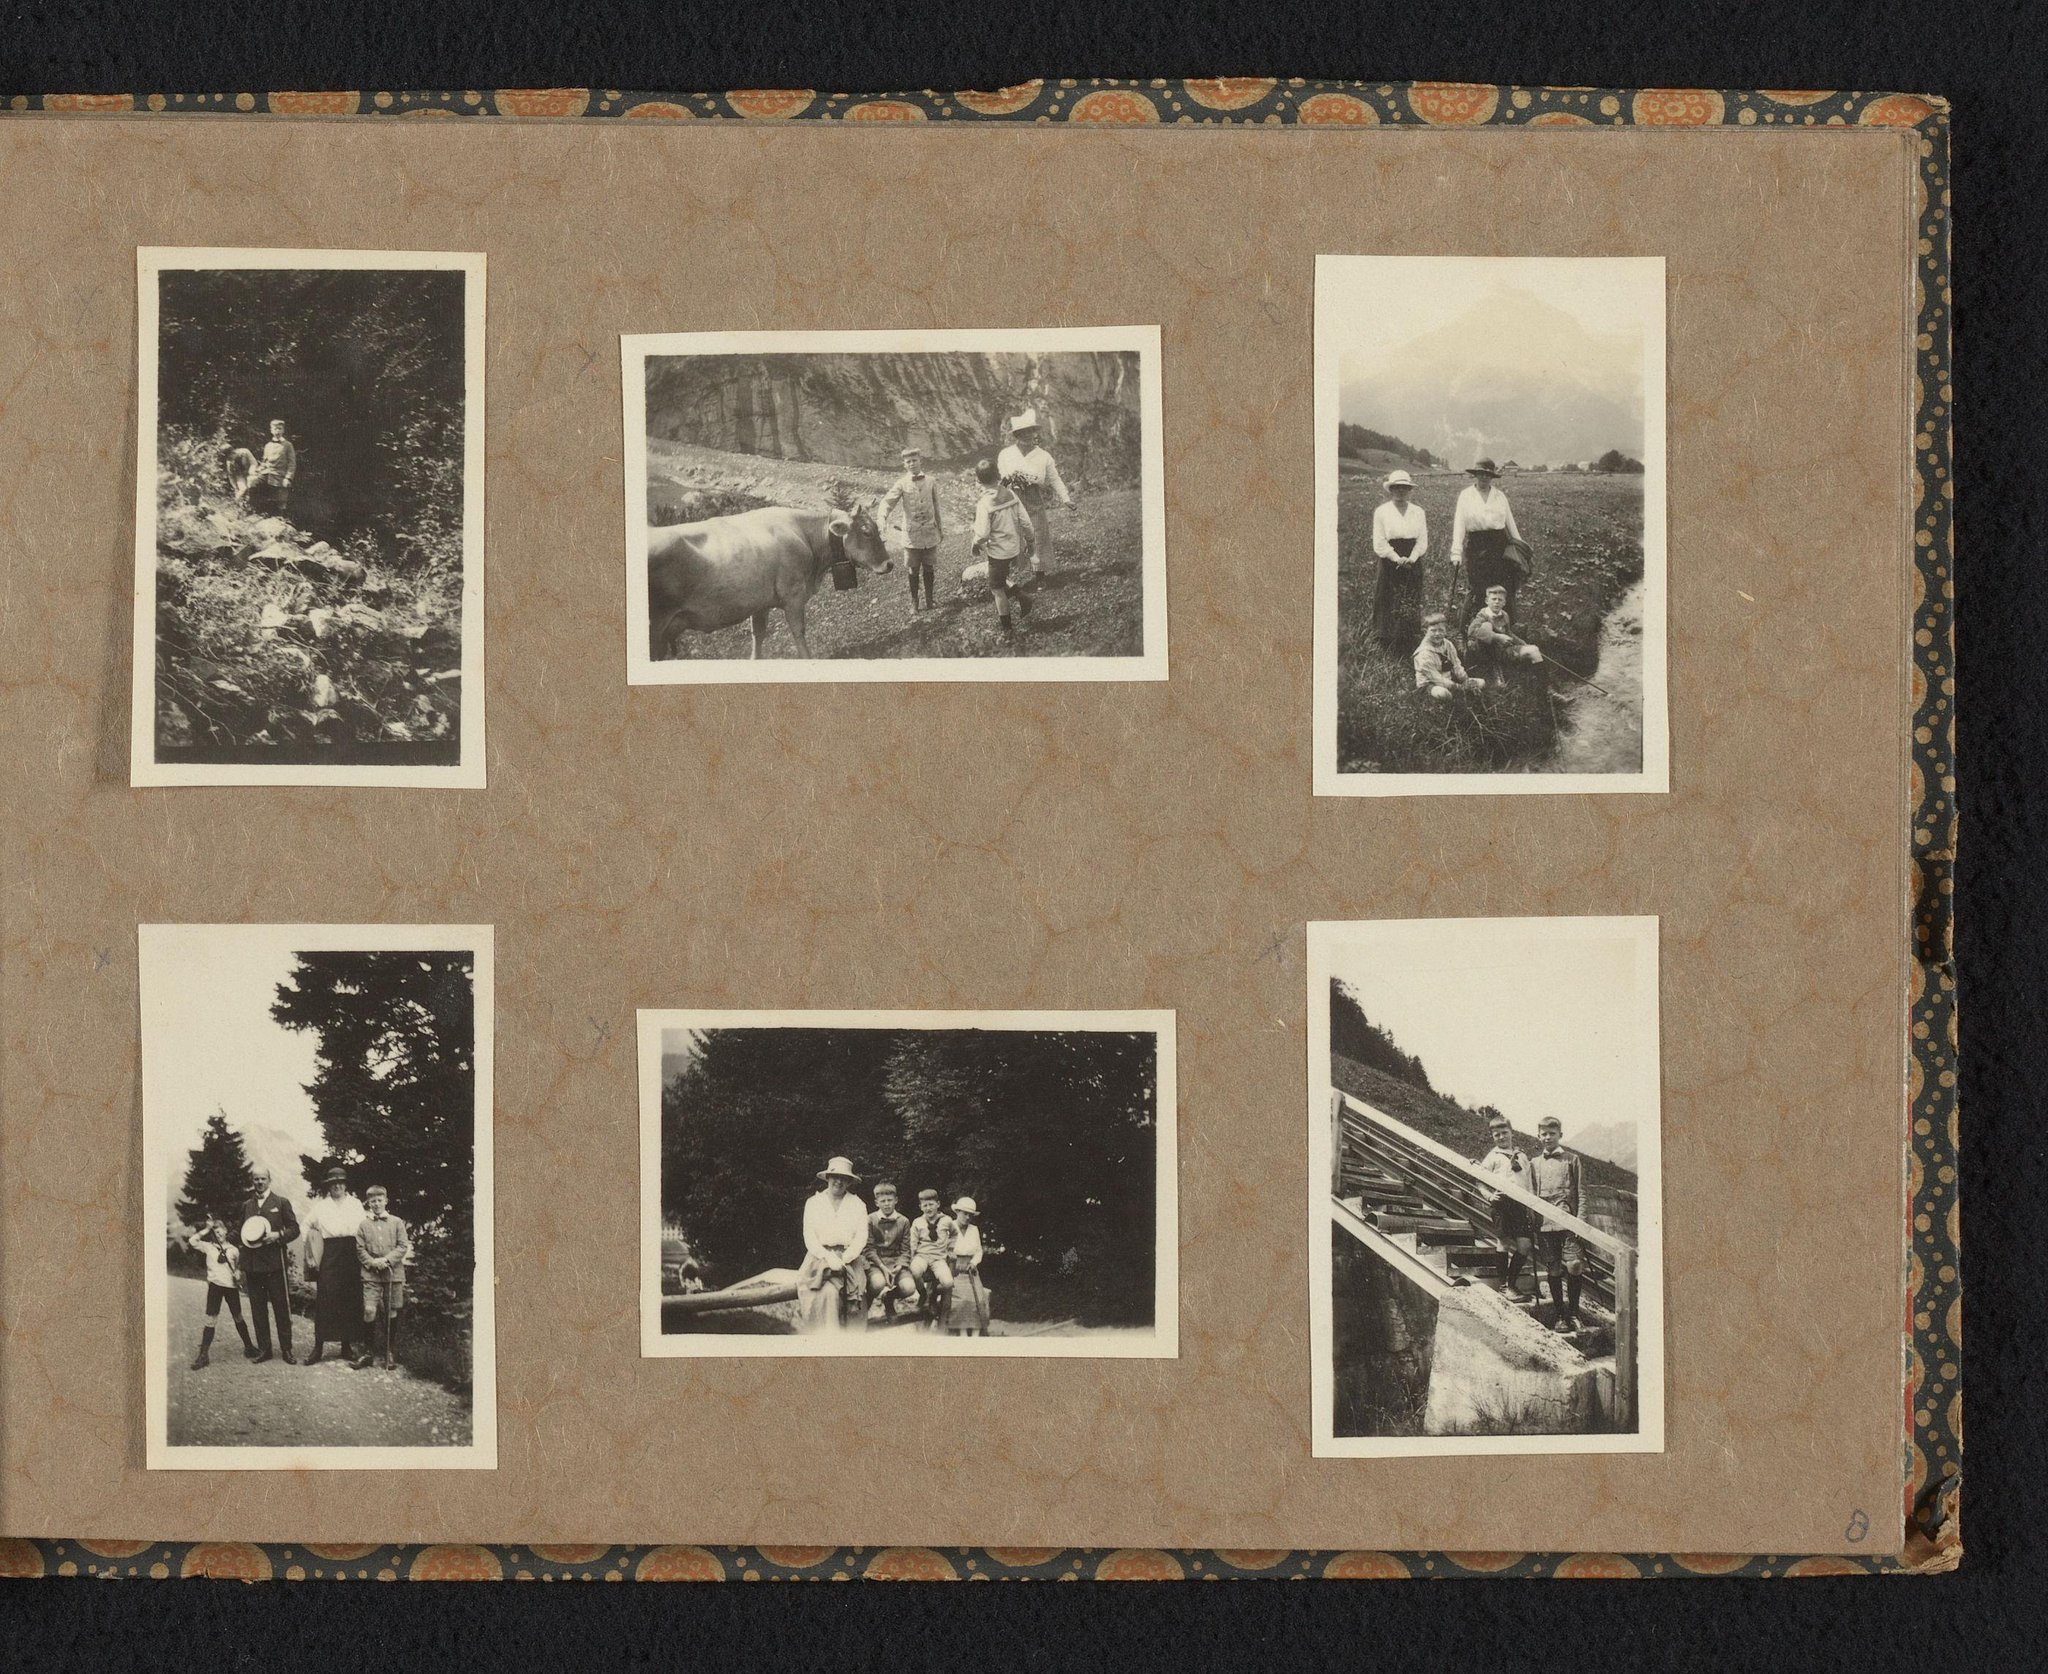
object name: album leaf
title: Zes foto's van familie Van den Berg tijdens wandelingen in de buurt van Engelberg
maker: hendrik herman van den berg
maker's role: amateurfotograaf, jurist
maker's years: 1875-1944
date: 1920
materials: paper, cardboard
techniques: gelatin silver print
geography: engelberg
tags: caroline louise van den berg-van den berg, amsterdam, carel frederik van den berg (cay), frank willem van den berg (1912-1998), the family travelling, on holiday, walking, hiking (recreation), historical persons, mountains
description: Deze foto's maken deel uit van een album.